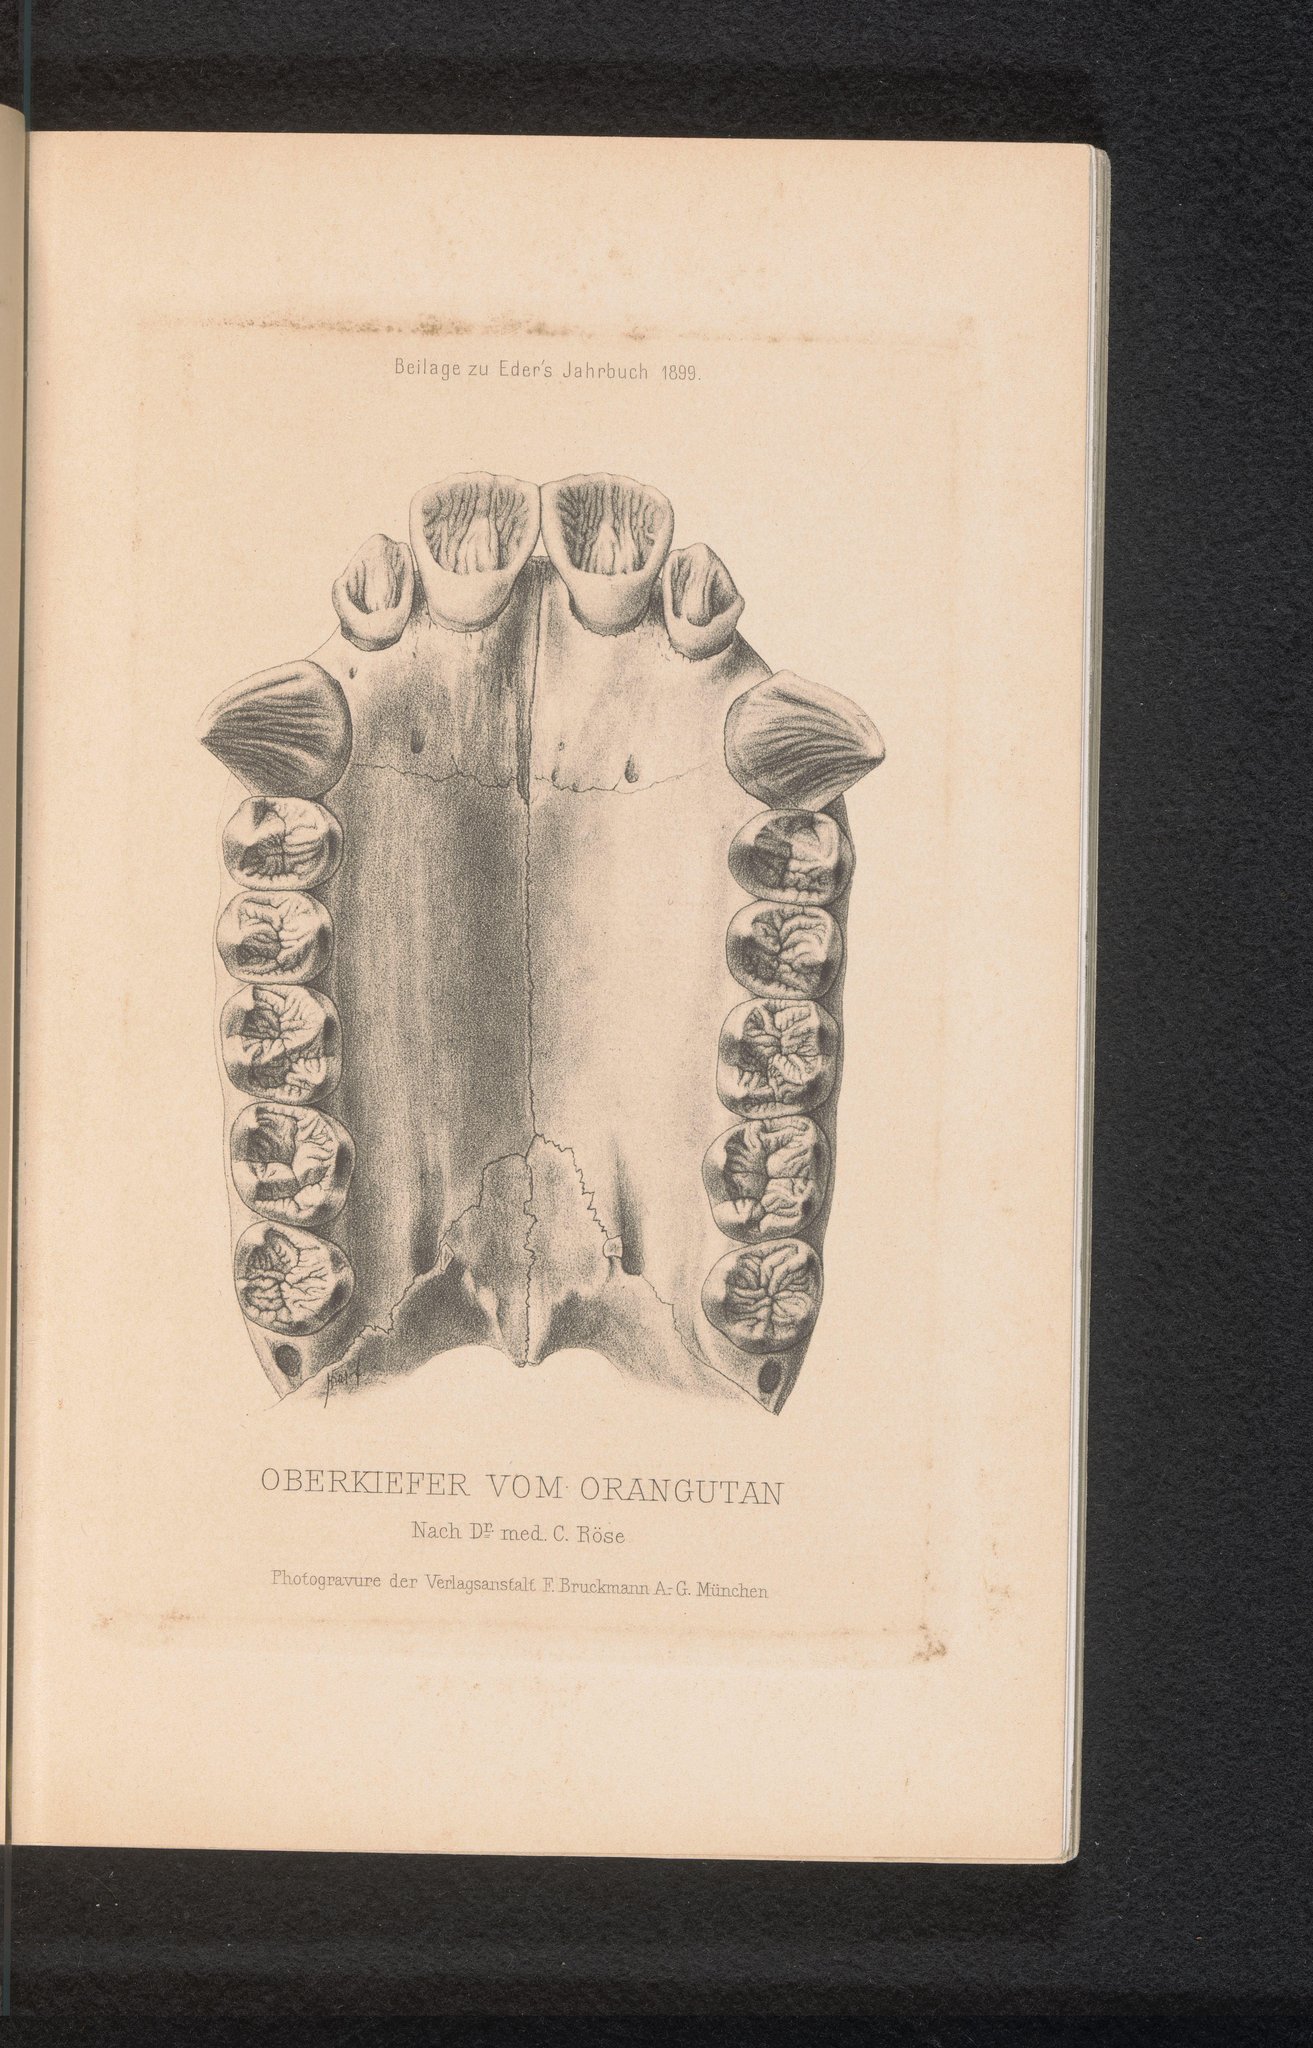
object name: page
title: Reproductie van een ontwerp van een bovenkaak van een orang-oetan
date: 1894-1899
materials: paper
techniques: photoaquatint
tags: monkeys, apes: orang-utan (skull of an animal)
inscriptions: inscription: ‘Beilage zu Eder's Jahrbuch 1899.’